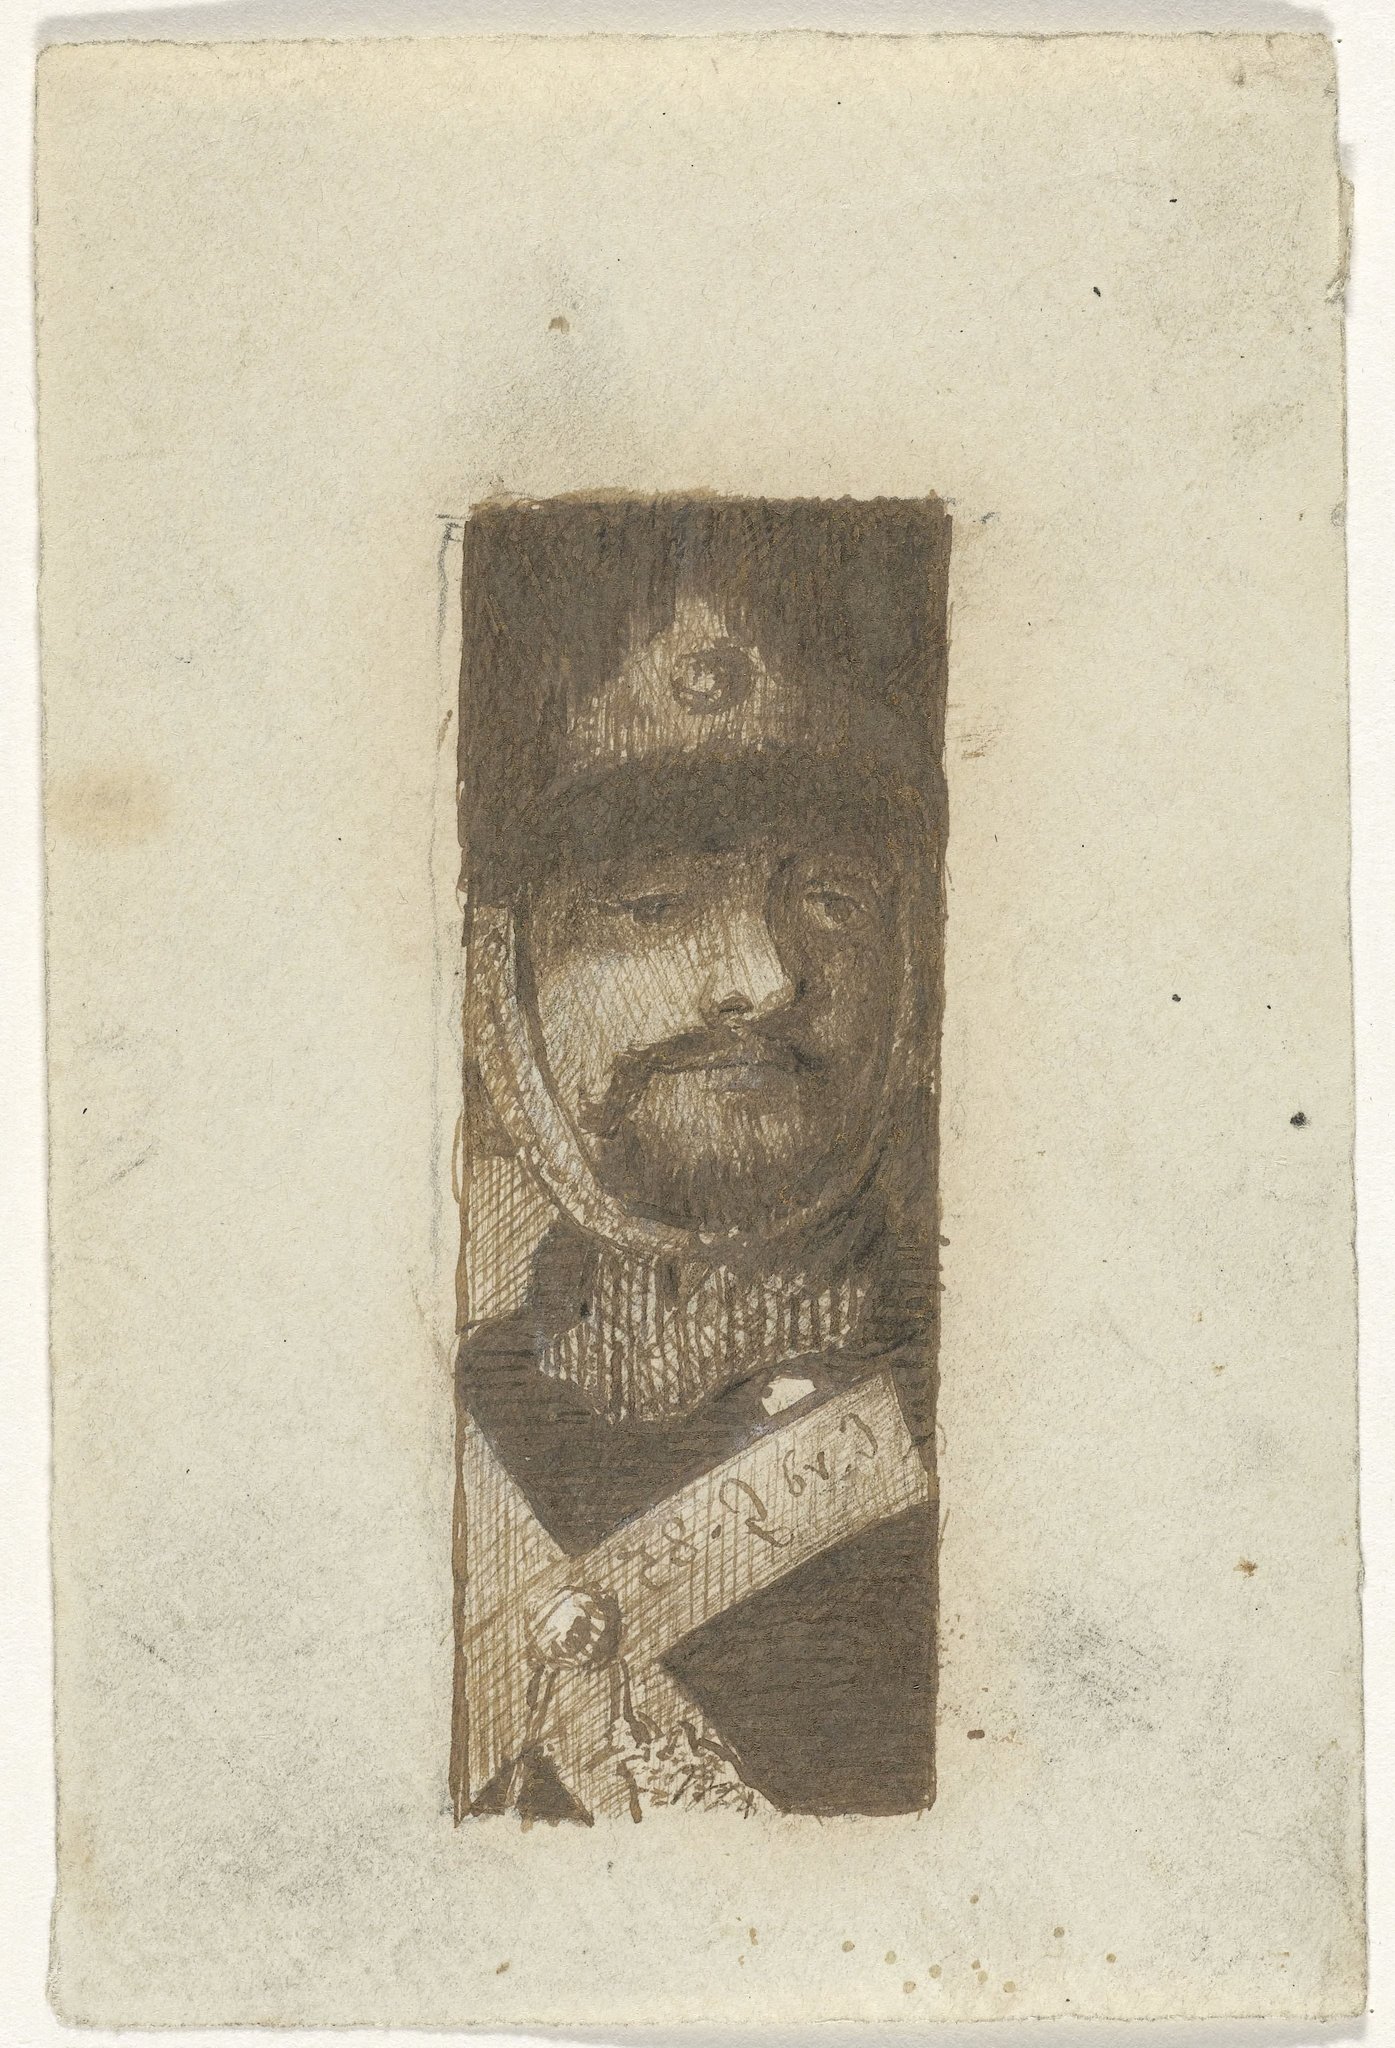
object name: drawing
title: Portret van een soldaat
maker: cornelis van der griendt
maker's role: draughtsman, painter, print maker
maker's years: 1827-1918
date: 1842-1918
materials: ink, paper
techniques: brush, pen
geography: netherlands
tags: private soldier, the soldier; the soldier's life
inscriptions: collector's mark: Lugt 2228